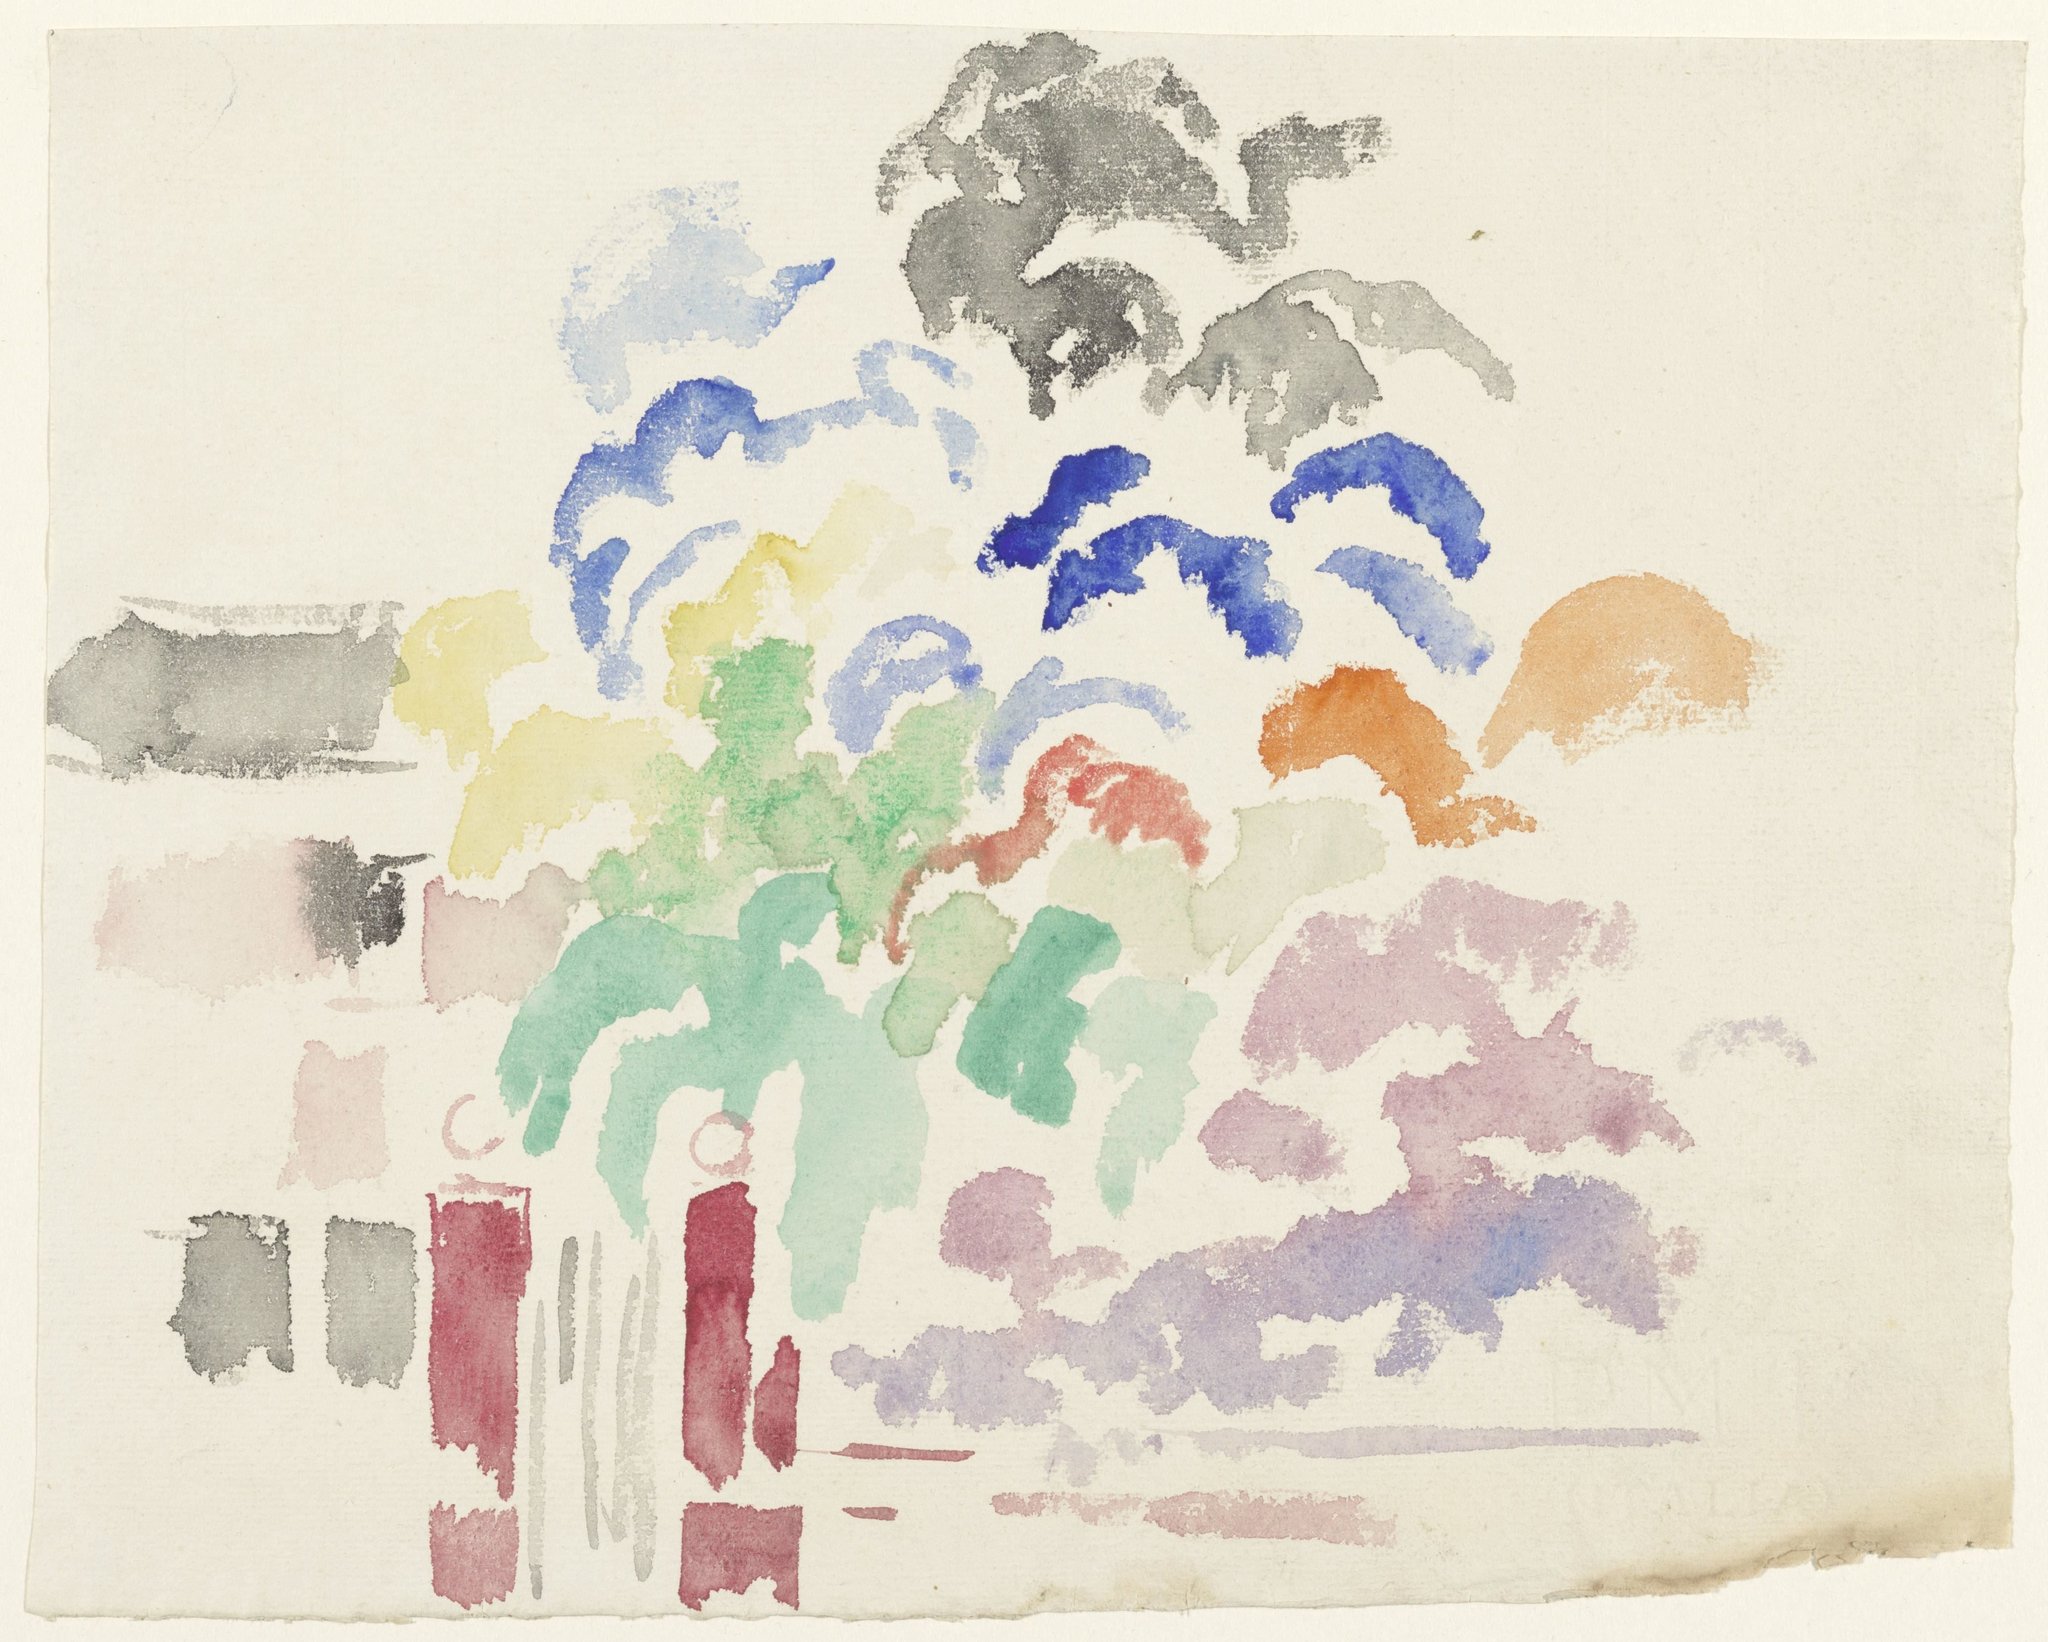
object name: drawing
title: Boitsfort, het hek van het park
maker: rik wouters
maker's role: draughtsman, print maker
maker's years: 1882-1916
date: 1892-1916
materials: paper, watercolor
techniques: brush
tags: public gardens, park, belgium